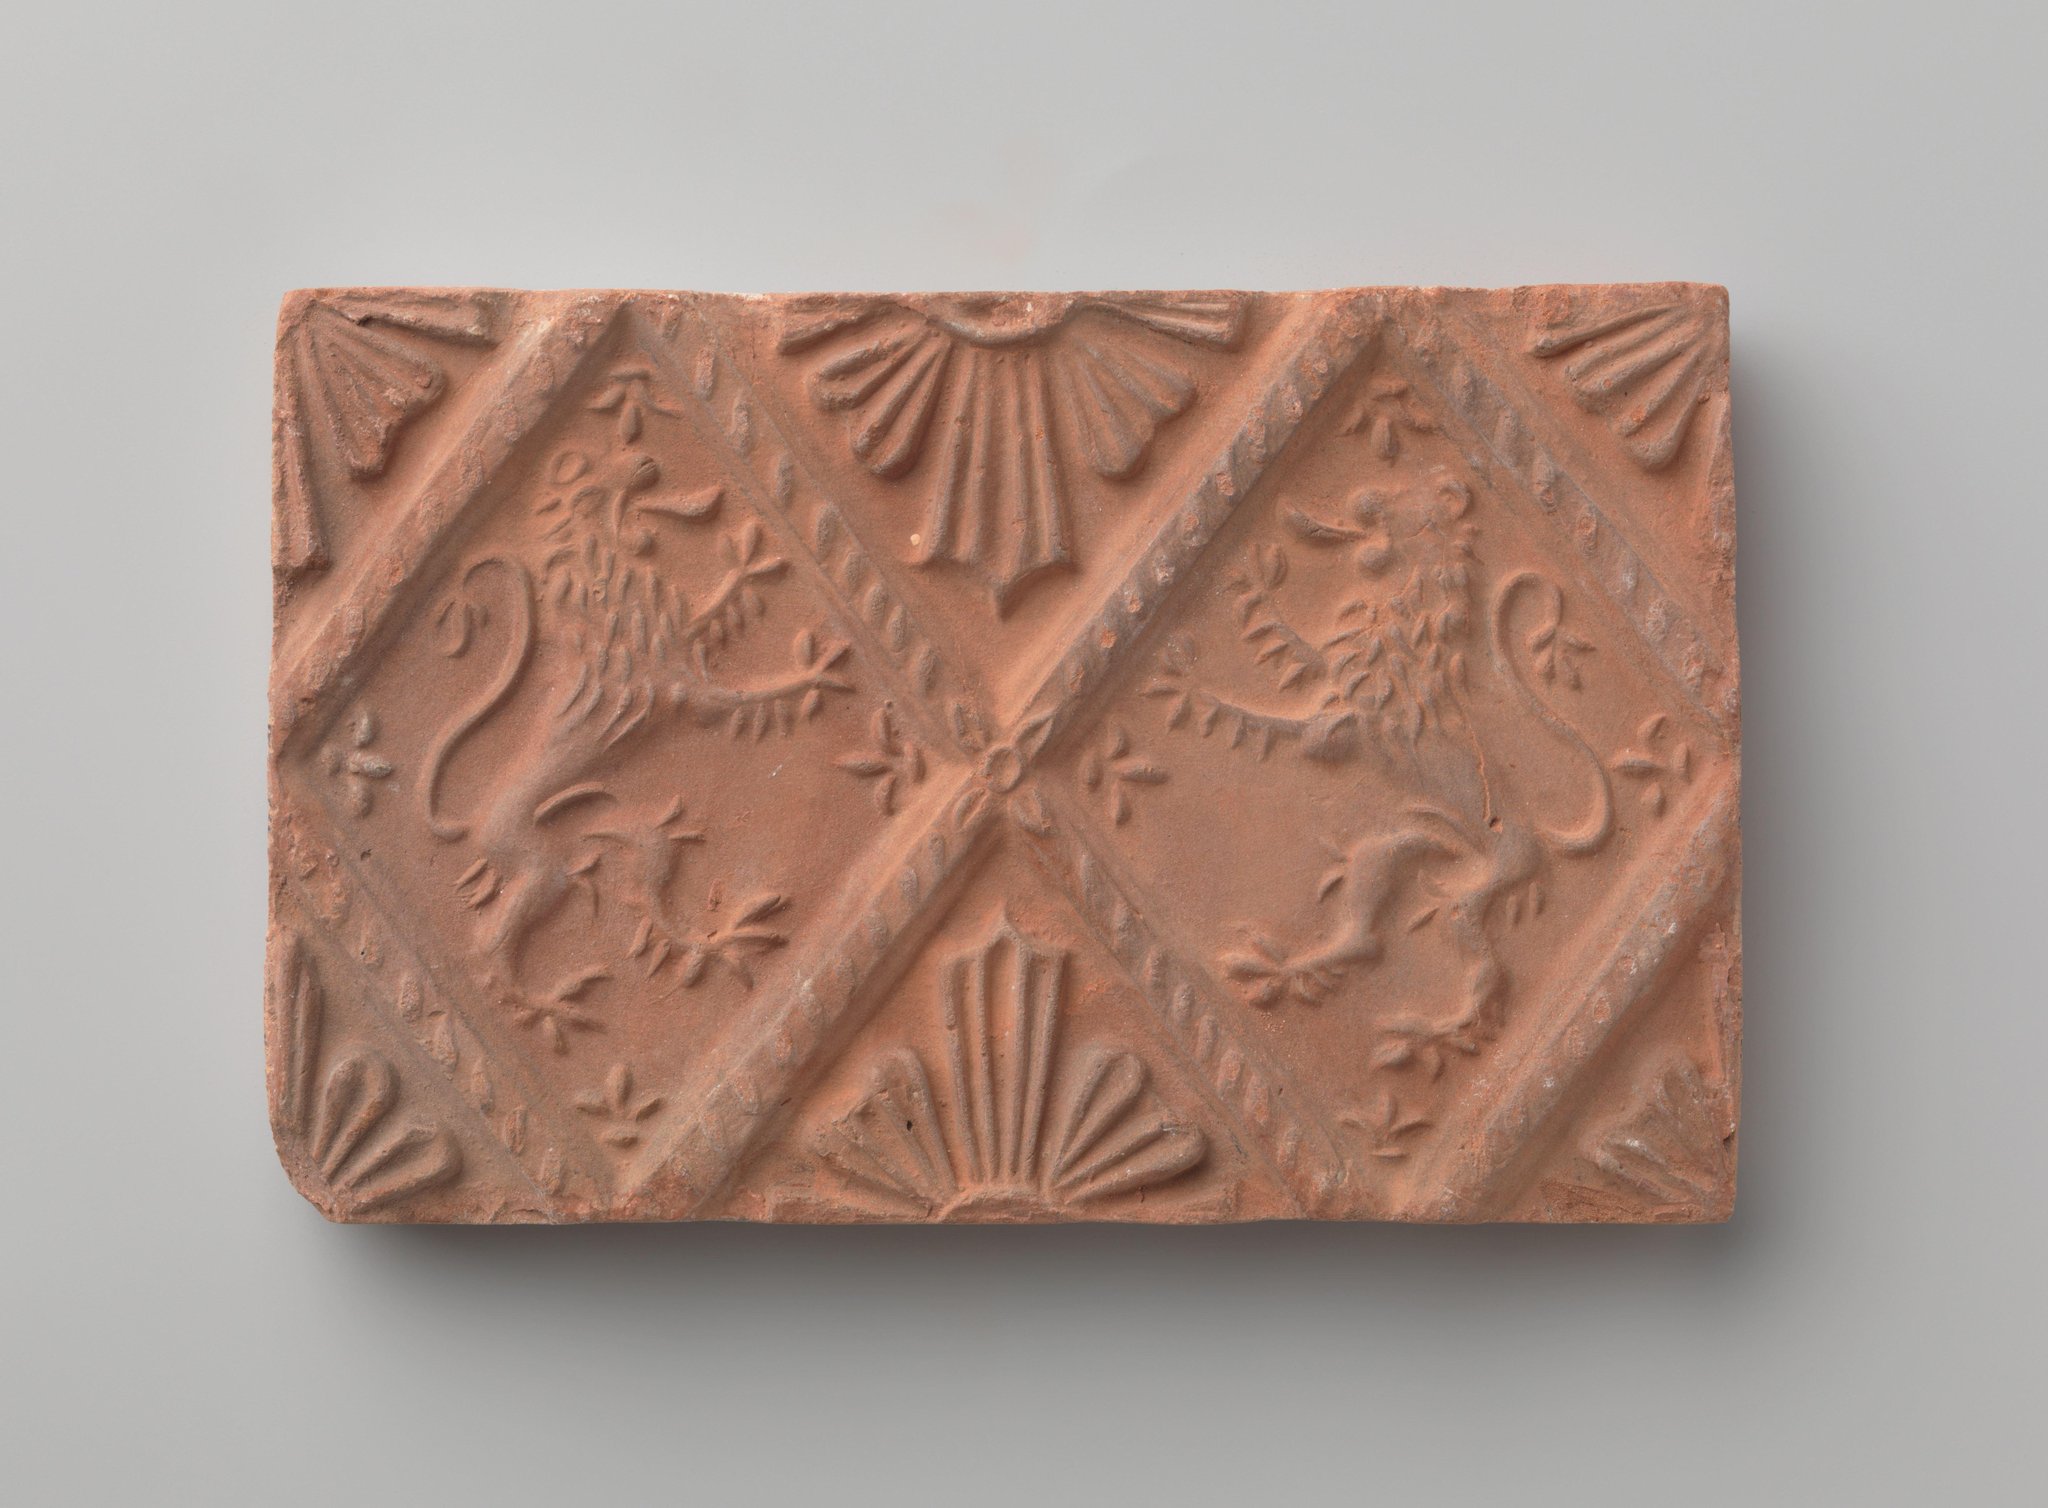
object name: hearthstone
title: Haardsteen met voorstelling van twee klimmende leeuwen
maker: Anonymous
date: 1875-1900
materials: earthenware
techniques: printing, firing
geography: netherlands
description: Haardsteen met voorstelling van twee klimmende leeuwen, geplaatst in geprofileerde ruit. De halve ruiten aan de boven- en onderkant zijn opgevuld met stermotief.